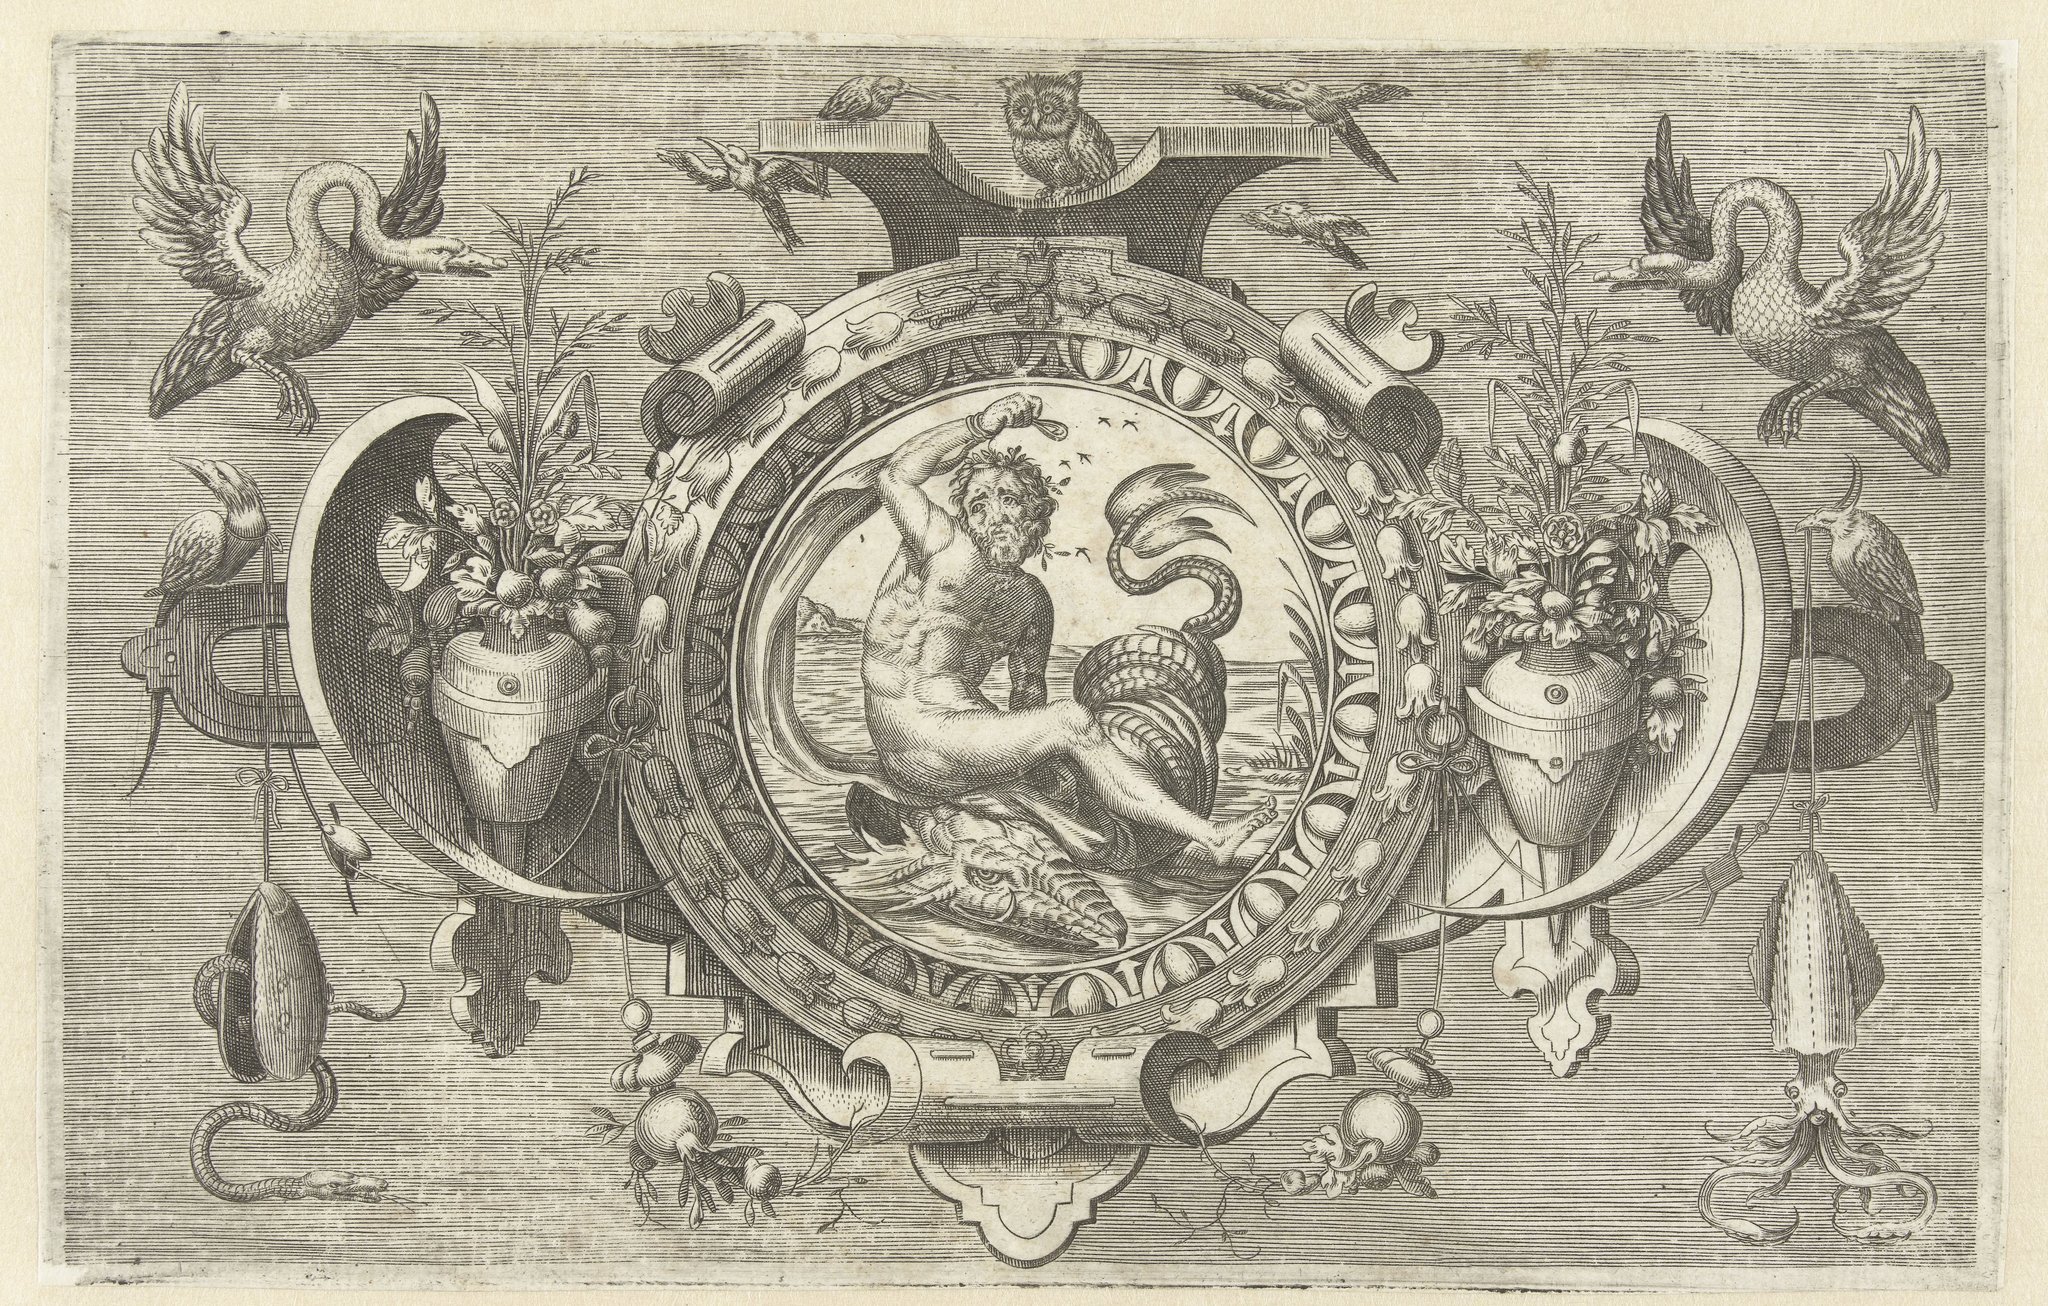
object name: ornament print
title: Veelderhande cierlijcke Compertementen (...)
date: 1564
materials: paper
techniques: engraving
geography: antwerp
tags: snakes, molluscs: squid, water-birds: swan, birds, vase ~ ornament, ornament ~ cartouche, owls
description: Cartouche met een man op een zeemonster, in een ronde omlijsting gedecoreerd met een tulpmotief en geflankeerd door twee vazen met bloemen en vruchten. Op het rolwerk zit bovenaan een uil. In beide bovenhoeken vliegt een zwaan. Aan de touwen in de bek van twee vogels bungelen een schelp met slang en een inktvis. Onderdeel van serie met titelblad en 12 bladen.